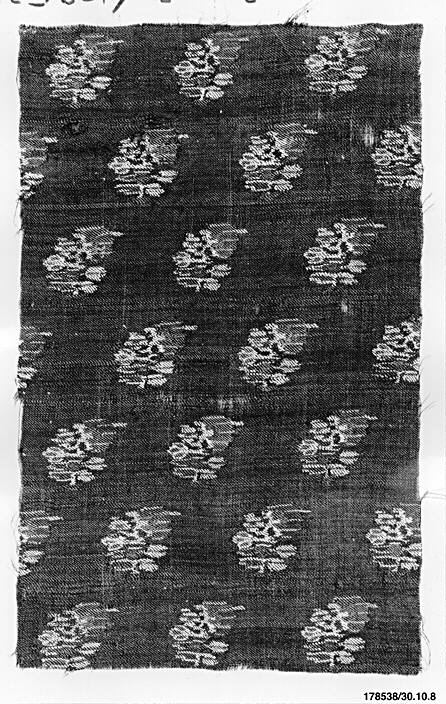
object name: textile fragment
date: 1800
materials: wool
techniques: brocade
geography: iran